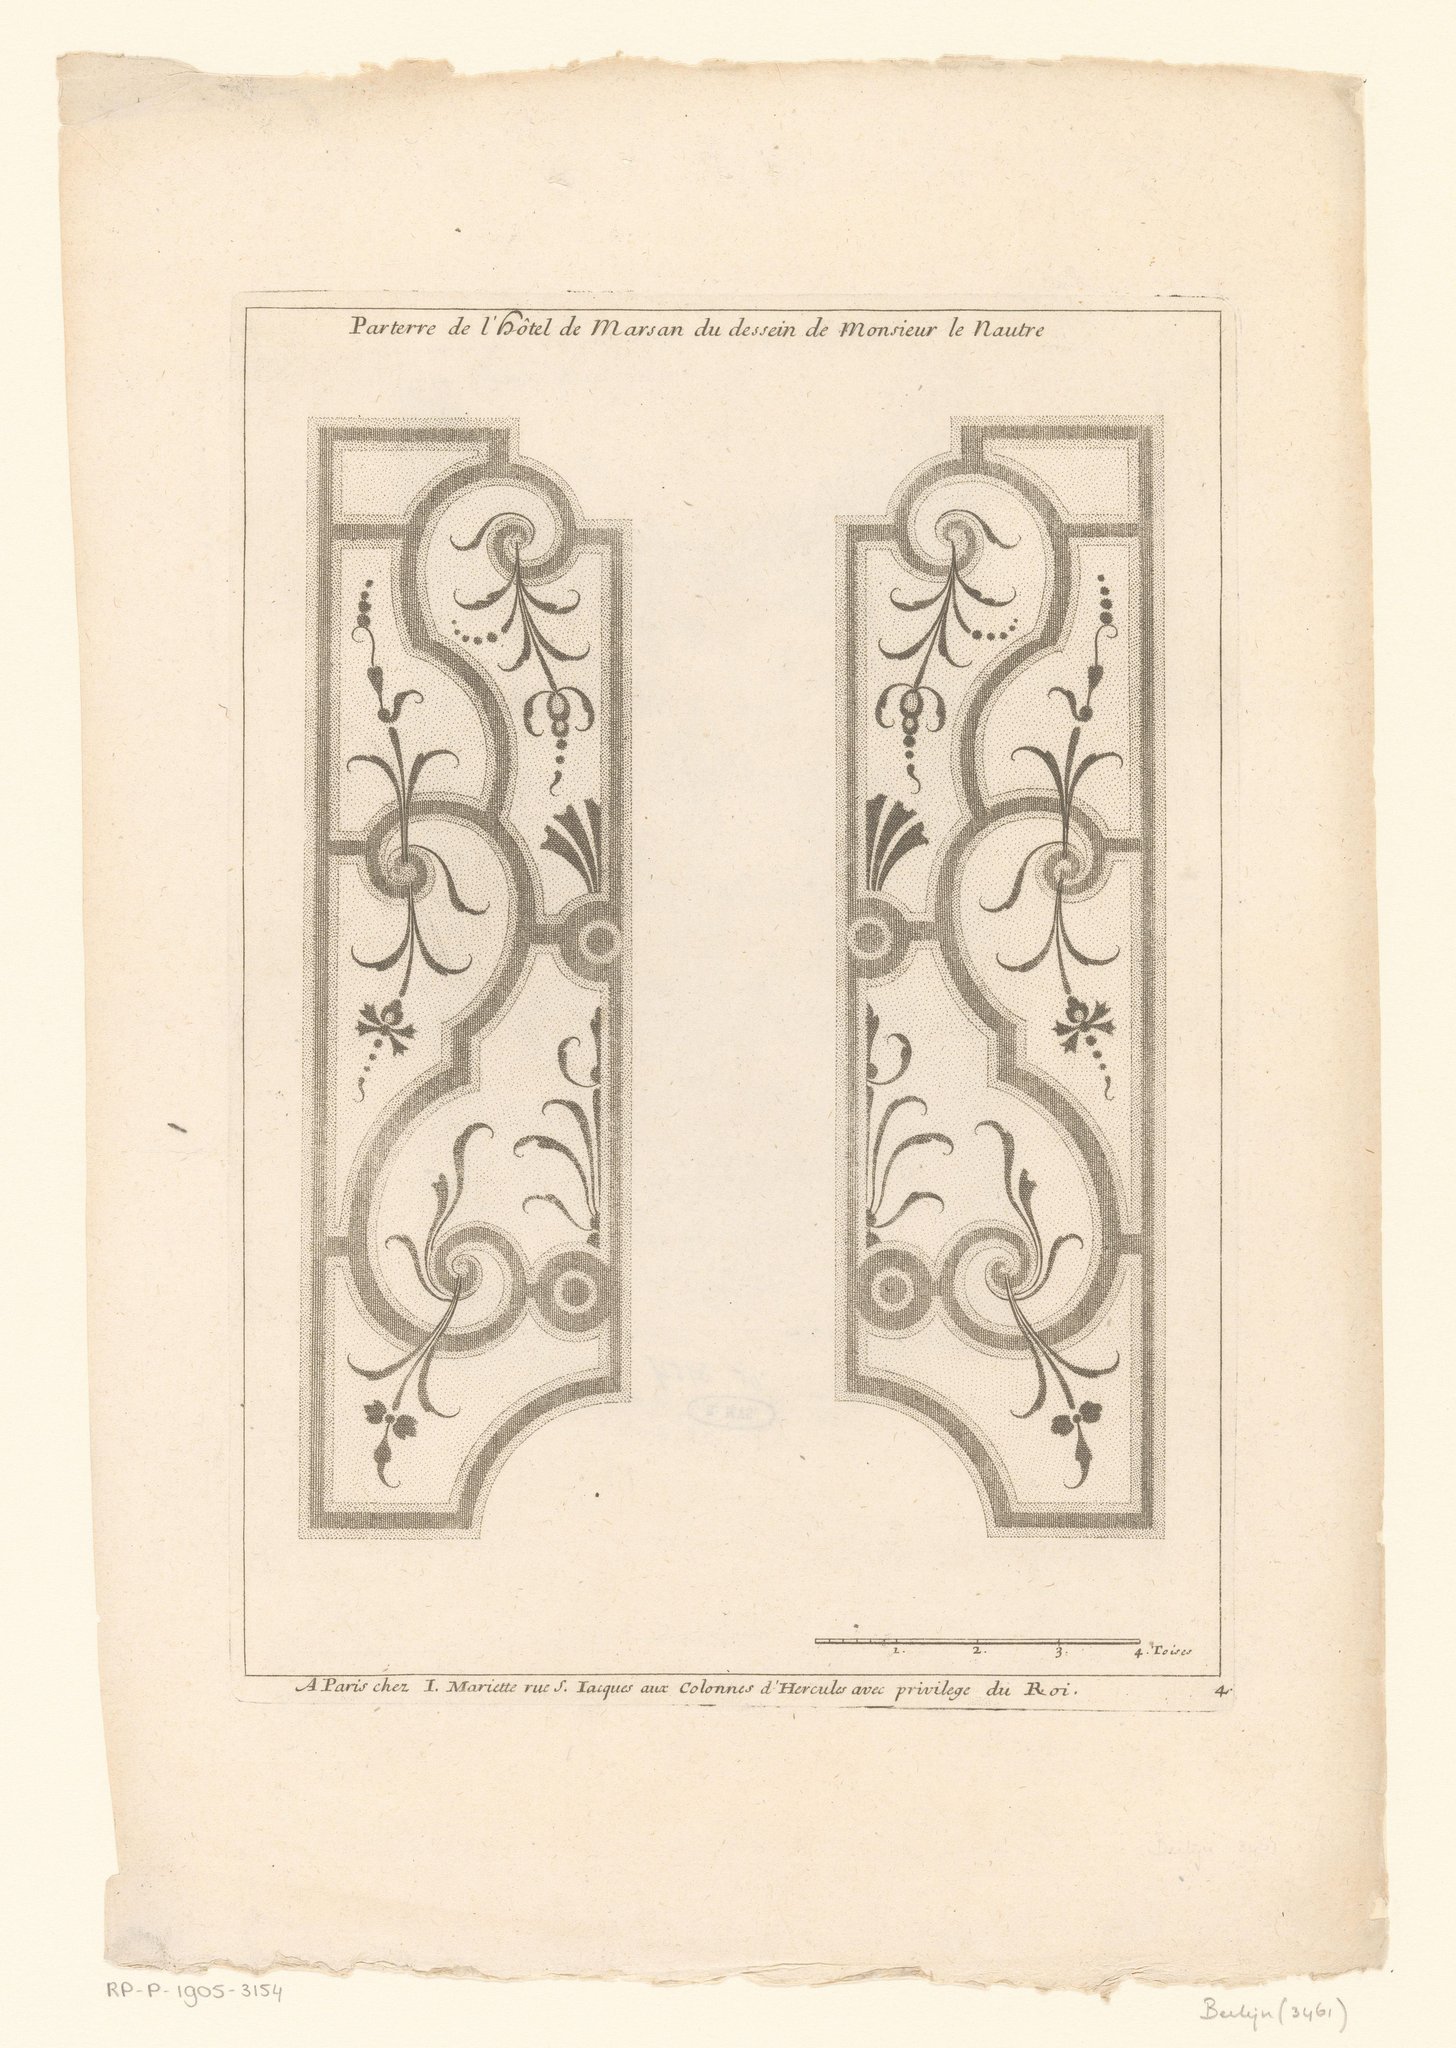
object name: print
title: Tuinparterres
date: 1691-1742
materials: paper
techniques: etching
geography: paris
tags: plan, map of garden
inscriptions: collector's mark: Lugt 2228